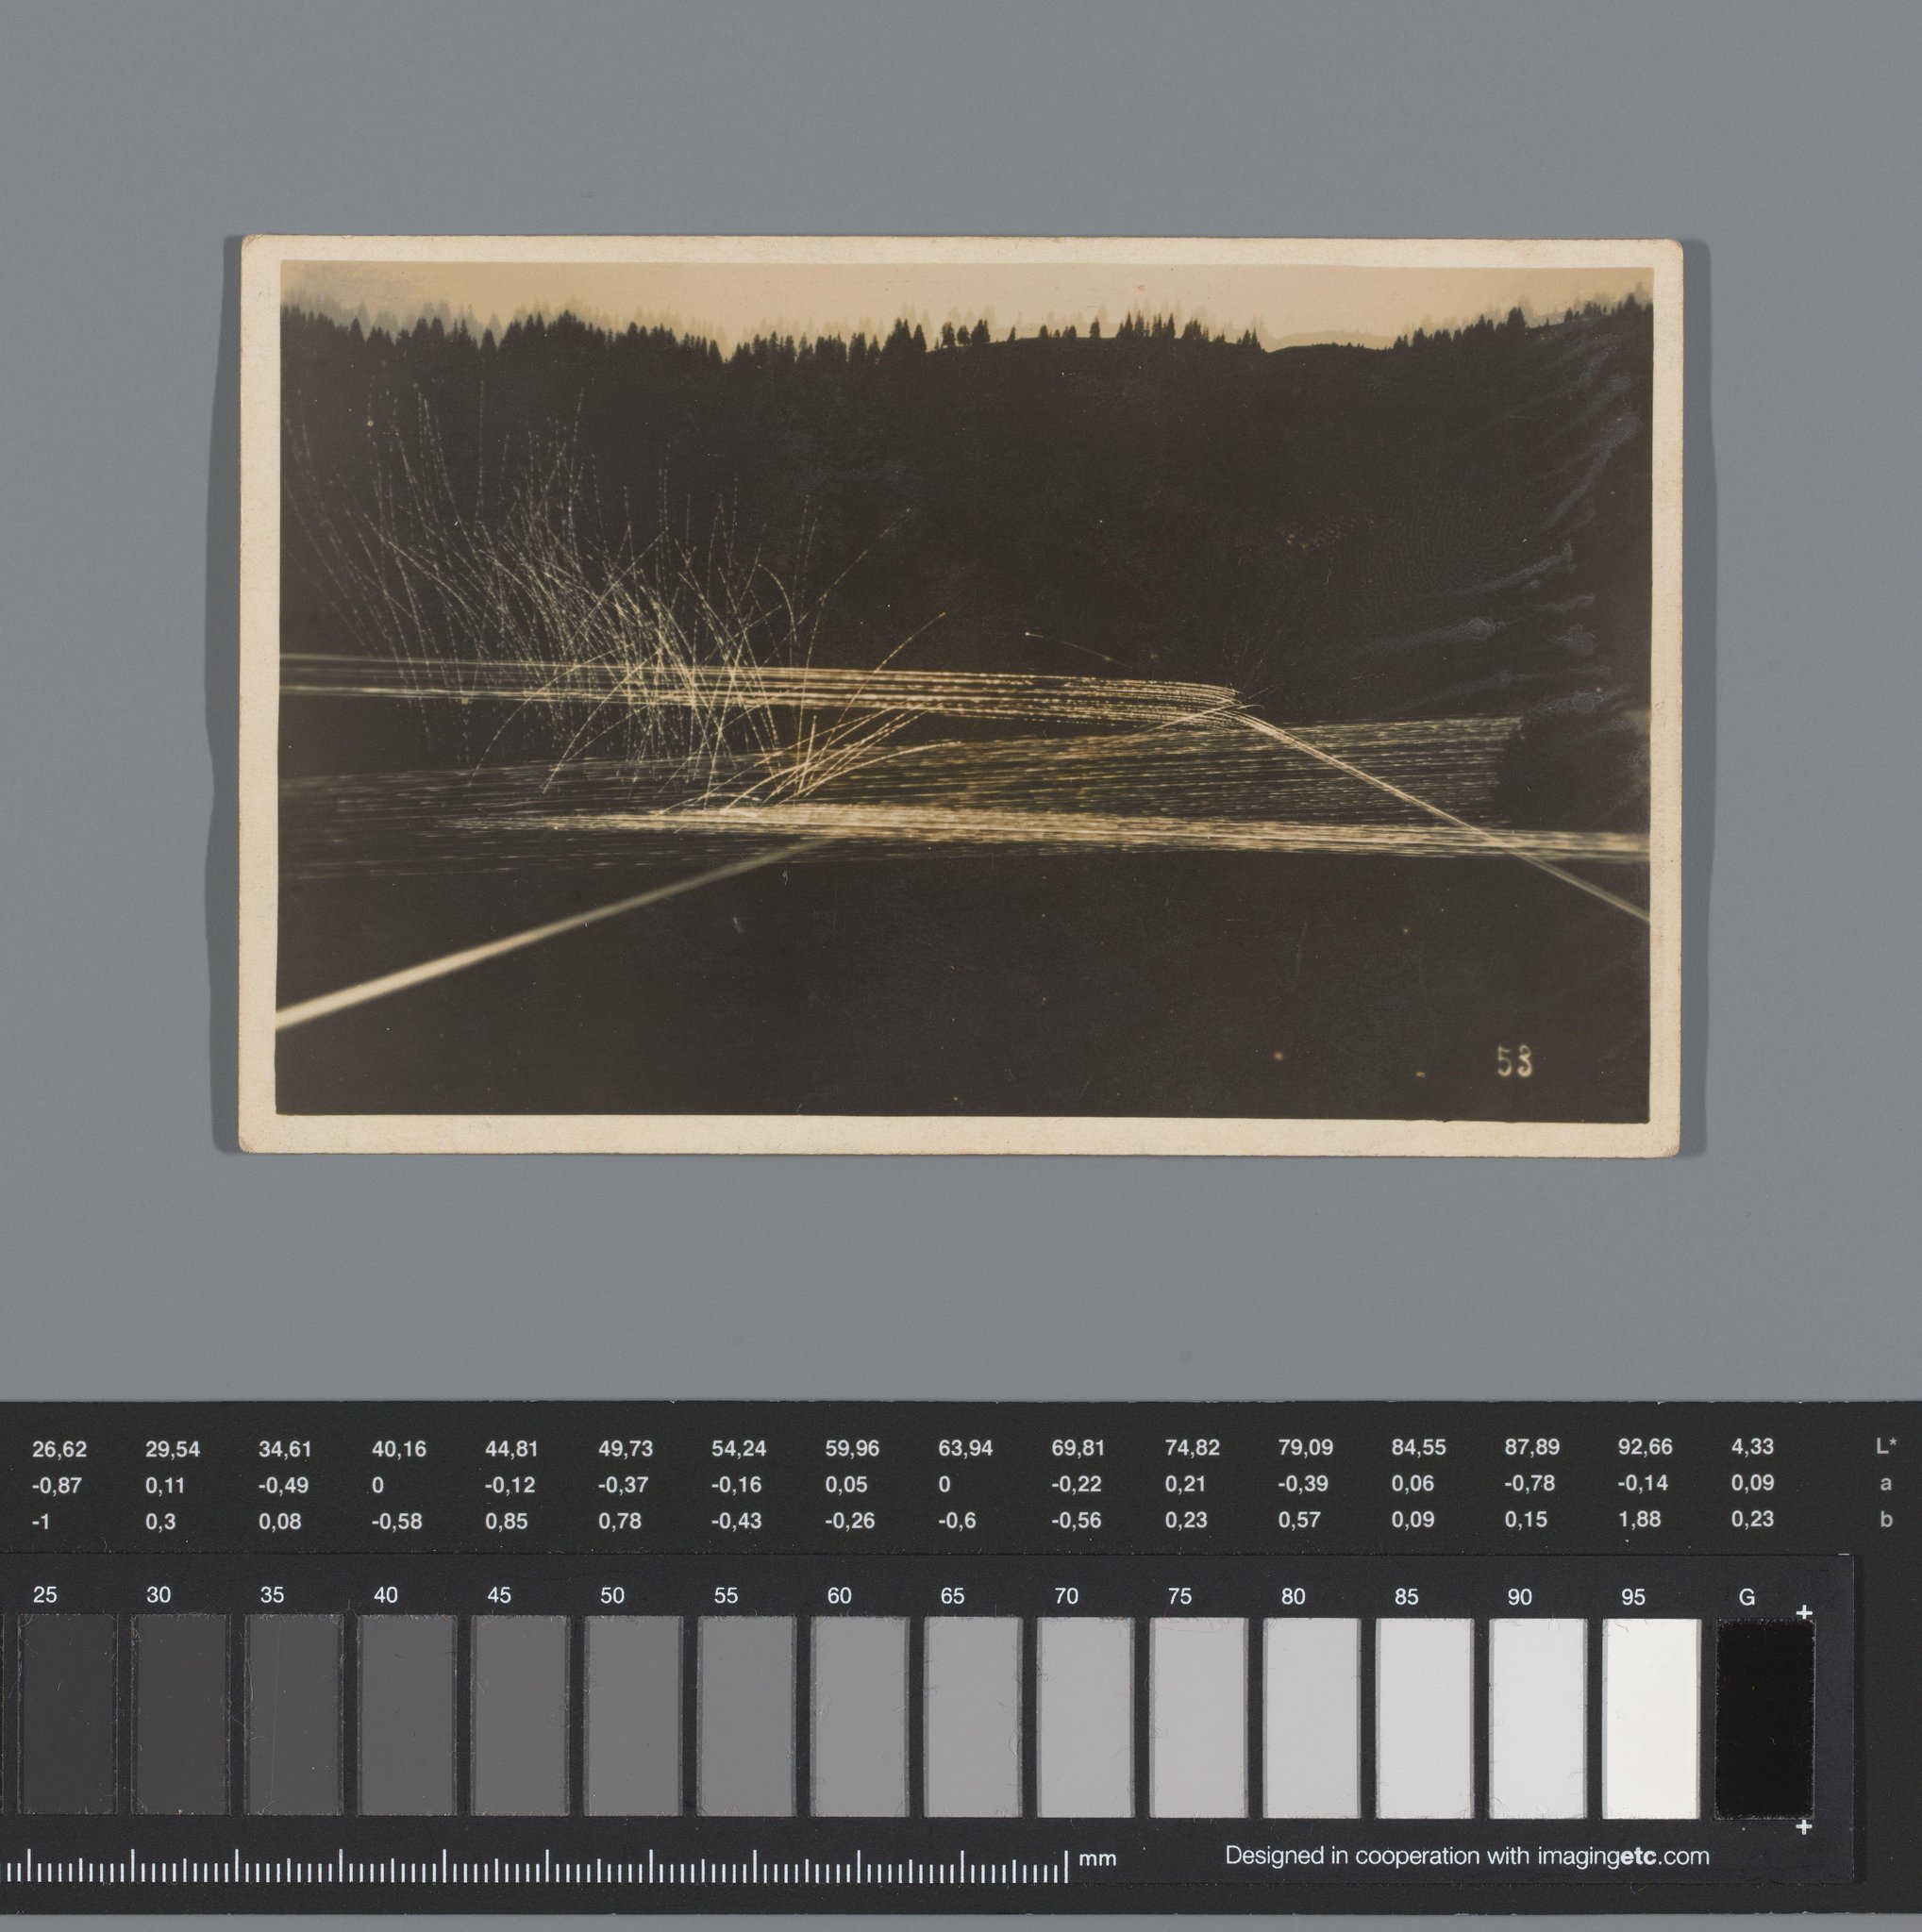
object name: photograph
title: Spervuur met mitrailleur(s) bij avond of nacht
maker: e. widmer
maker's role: fotograaf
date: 1930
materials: paper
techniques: gelatin silver print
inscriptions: inscription: ‘Fauchage [?] en / élévation / mitrailleuse’, name: ‘PHOTO WIDMER, WALLENSTADT’, number: ‘53’